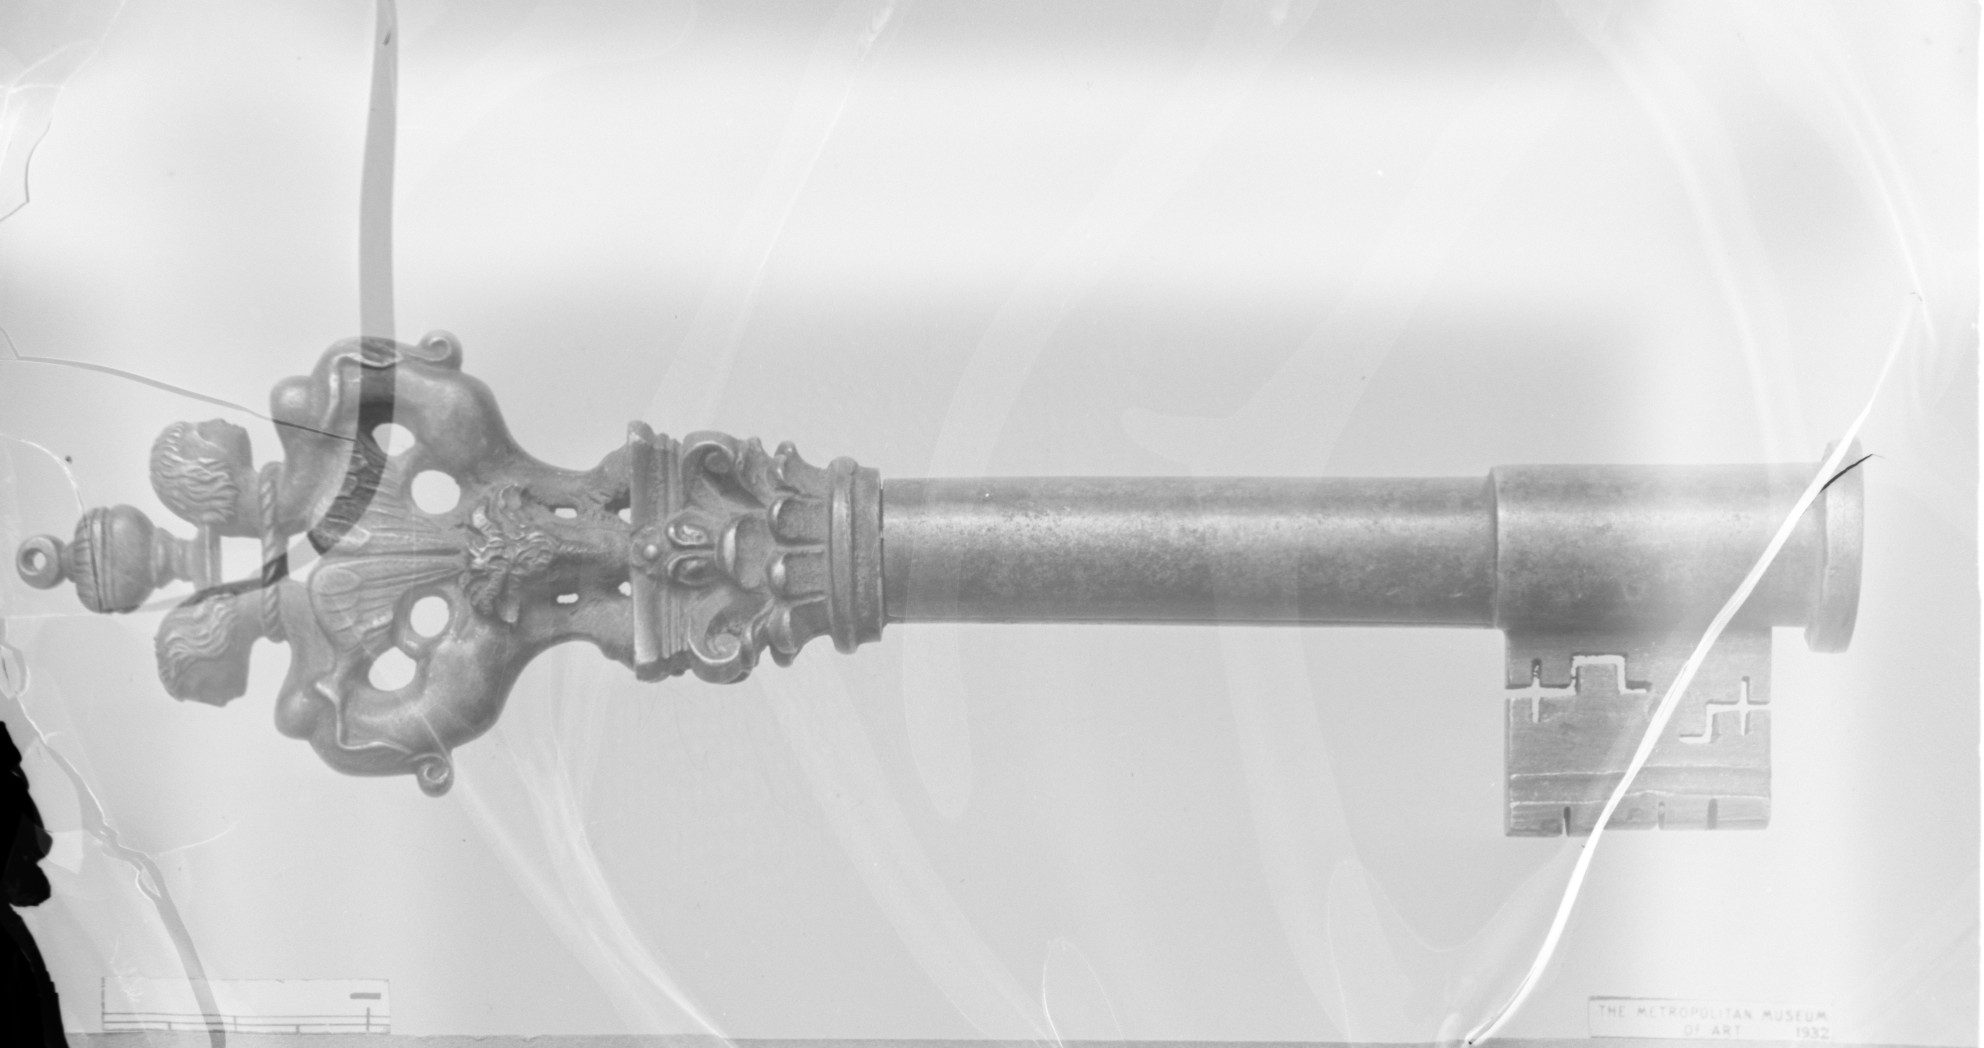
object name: key with sheath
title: Key with removable sheath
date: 1567-1633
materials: iron